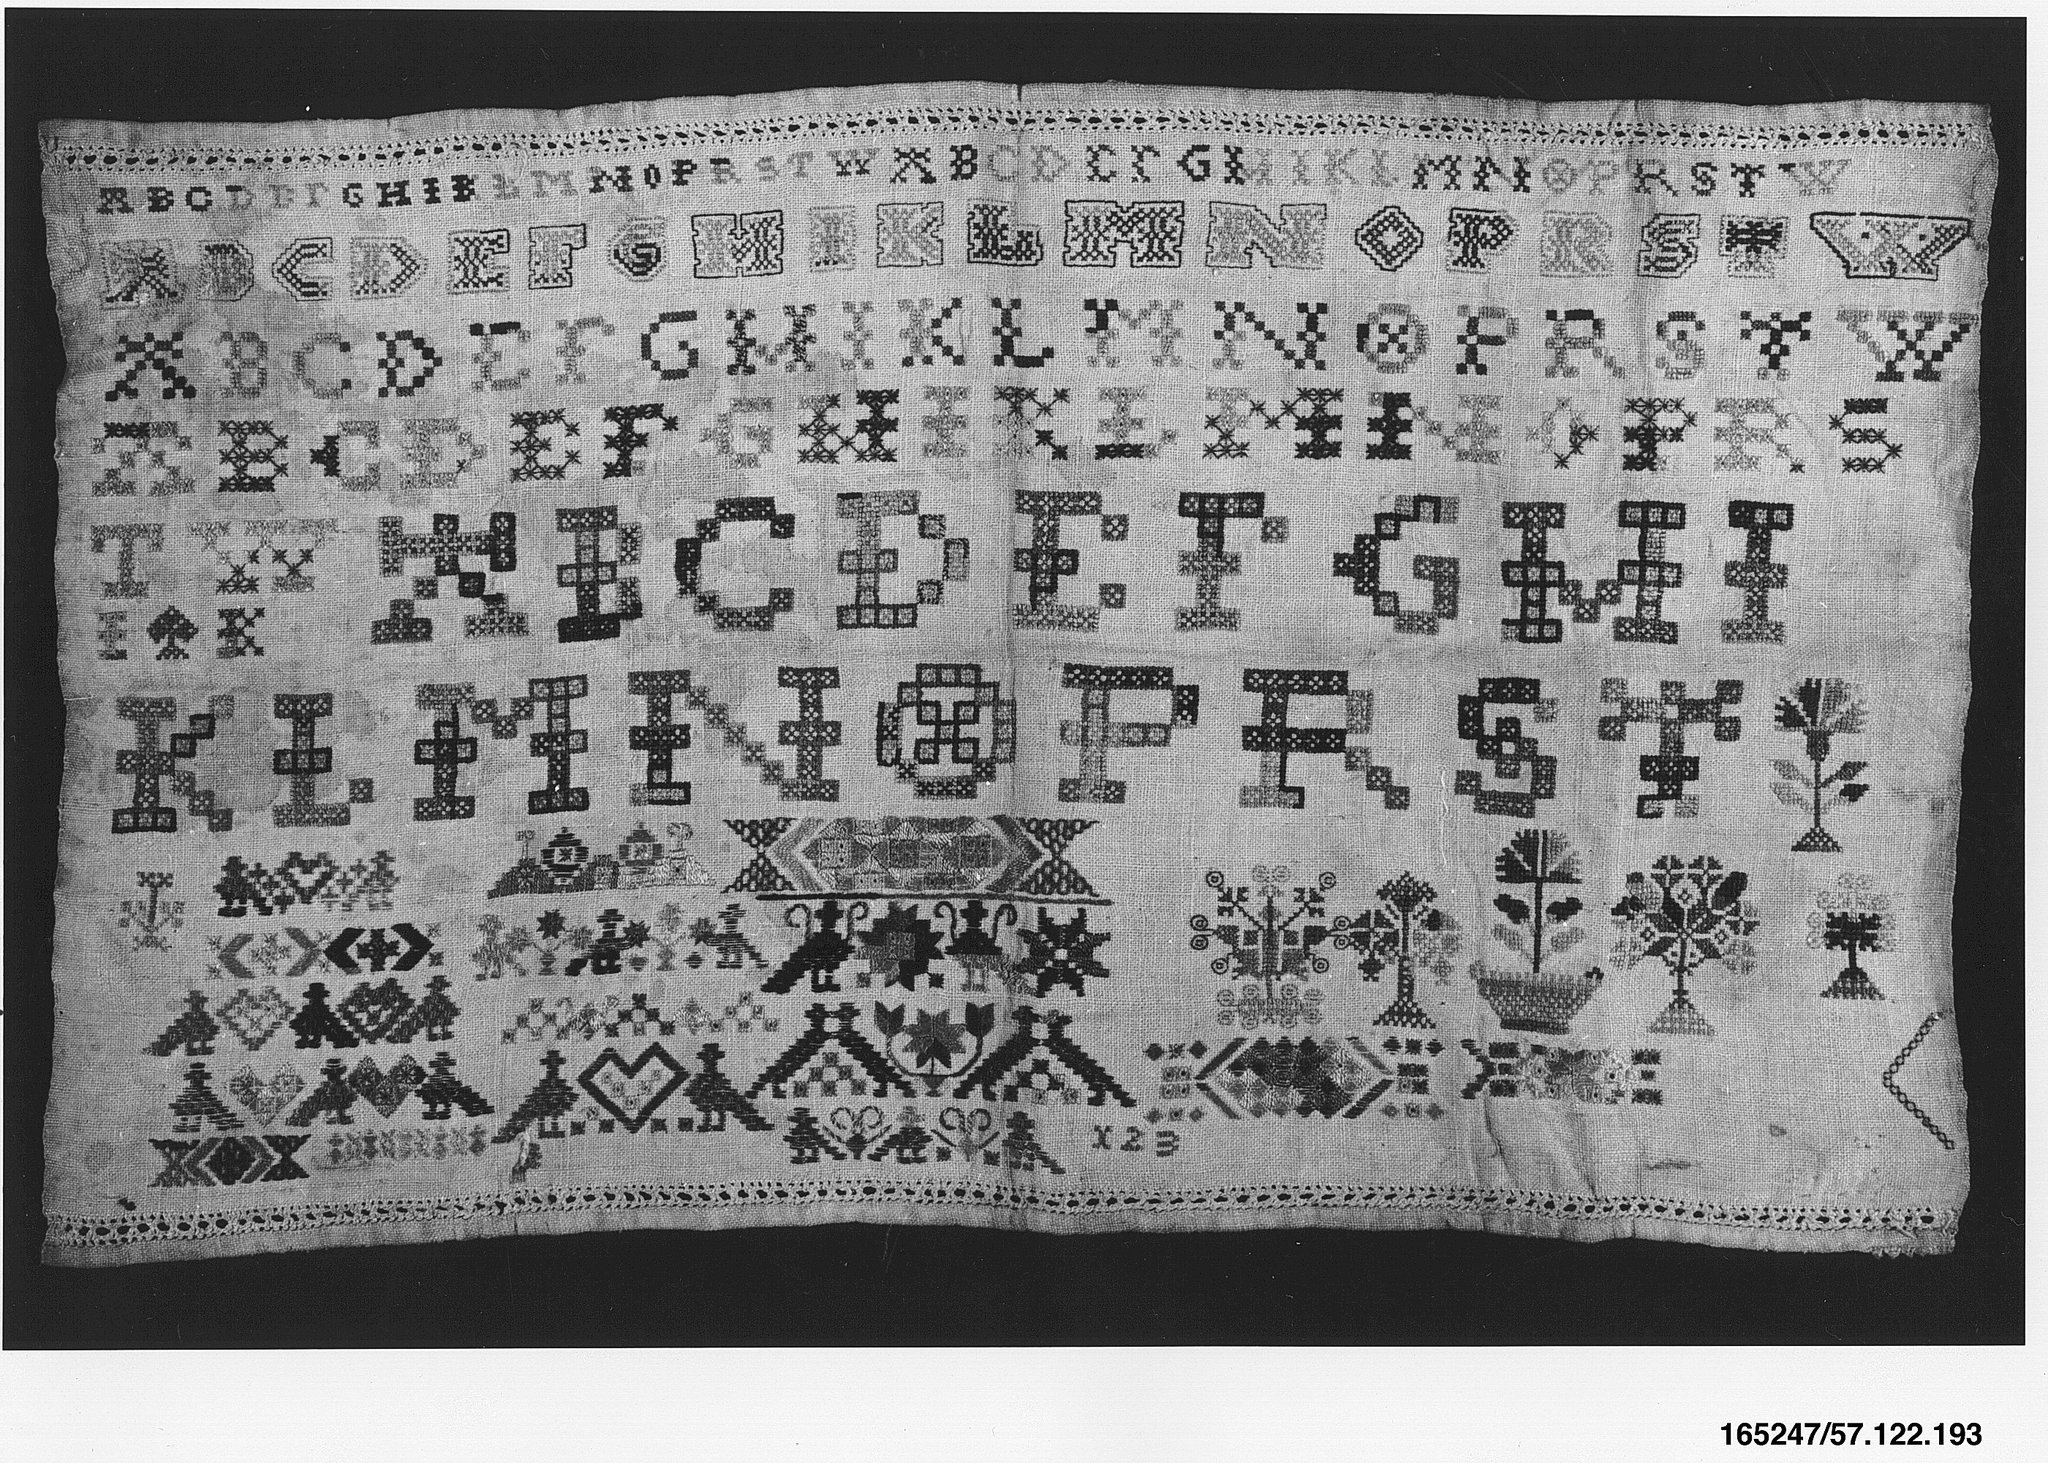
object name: sampler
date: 1701-1800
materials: linen, silk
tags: birds,flowers